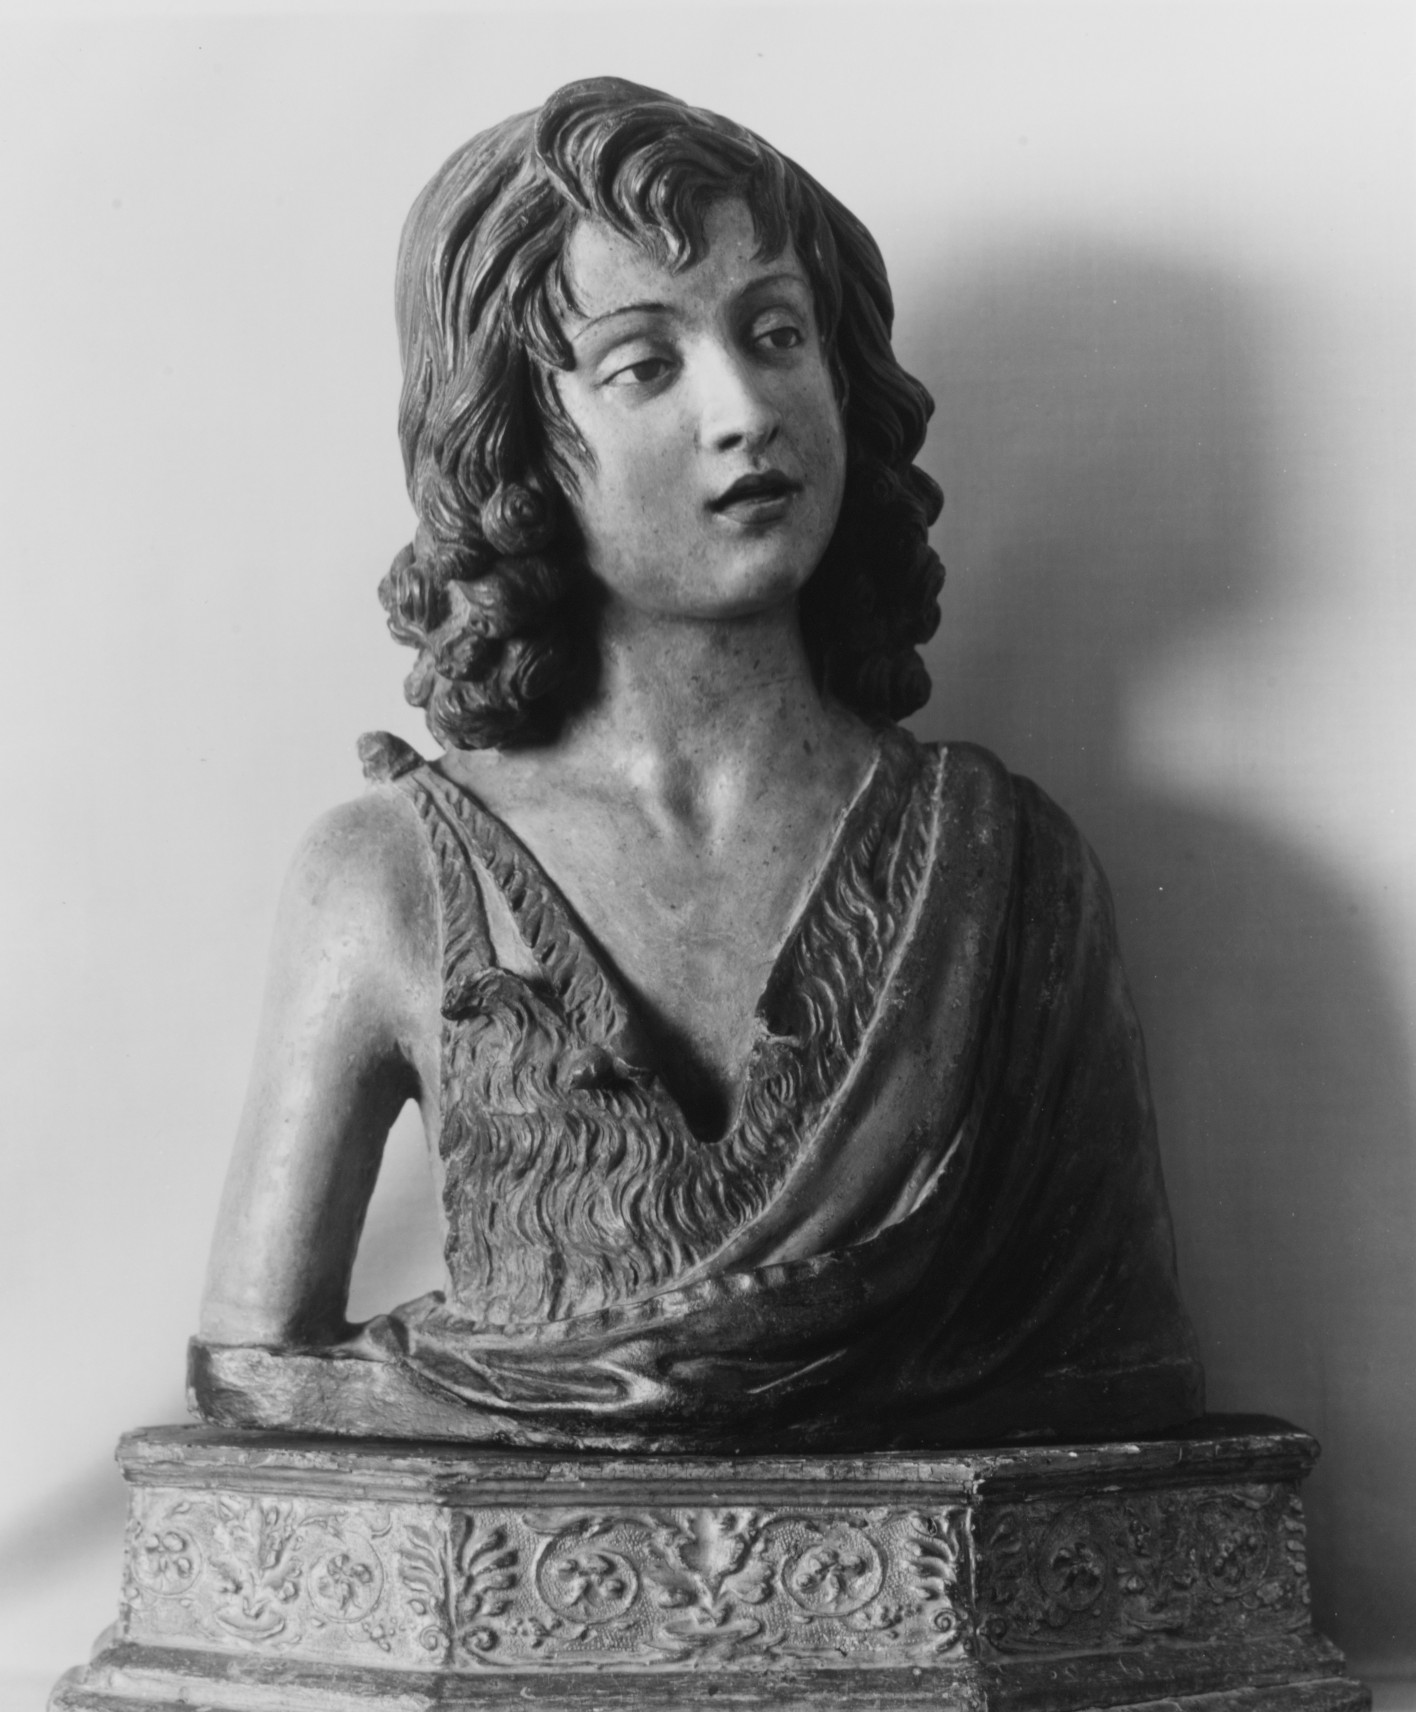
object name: bust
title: Saint John the Baptist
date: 1467-1500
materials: terracotta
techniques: polychrome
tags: saint john the baptist